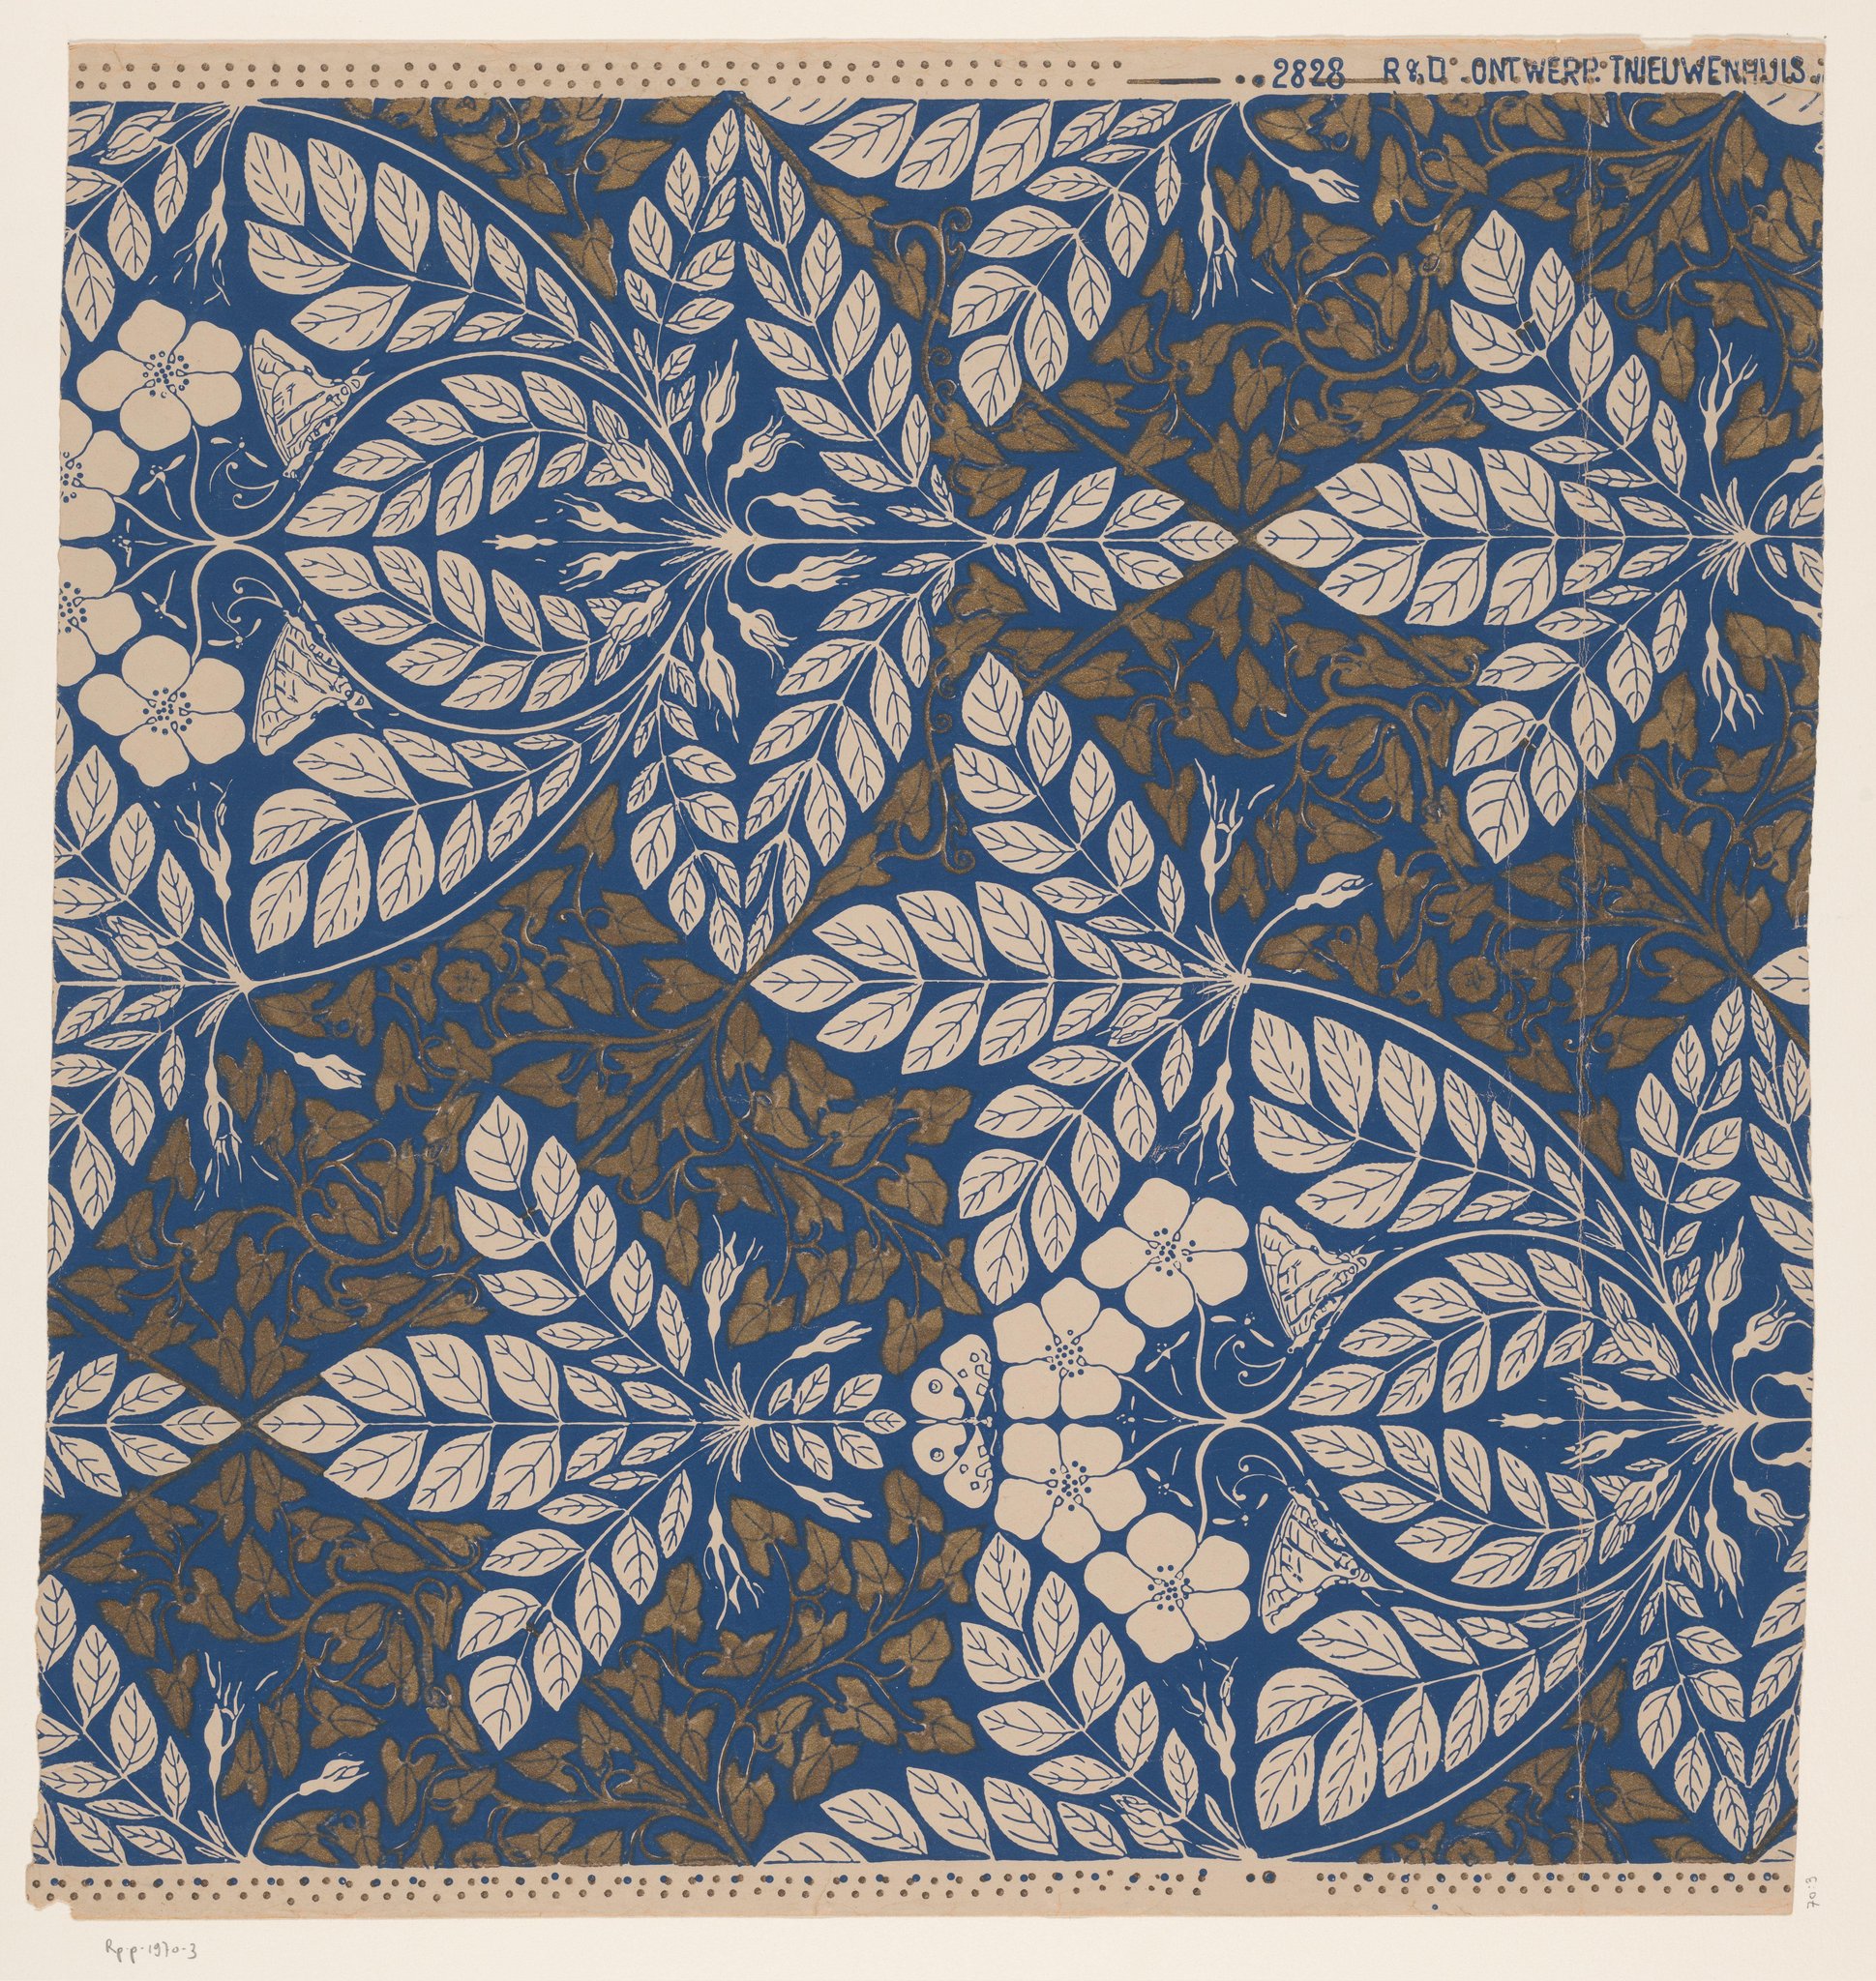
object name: print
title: Ontwerp voor behang met bladeren en bloemen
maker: theo nieuwenhuis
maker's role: designer, draughtsman, print maker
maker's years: 1866-1951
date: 1876-1951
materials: paper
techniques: lithograph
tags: foliage, tendrils, branches ~ ornament, flowers ~ ornament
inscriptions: collector's mark: Lugt 2228, collector's mark: Lugt 2760, inscription: ‘2828 R&D Ontwerp’